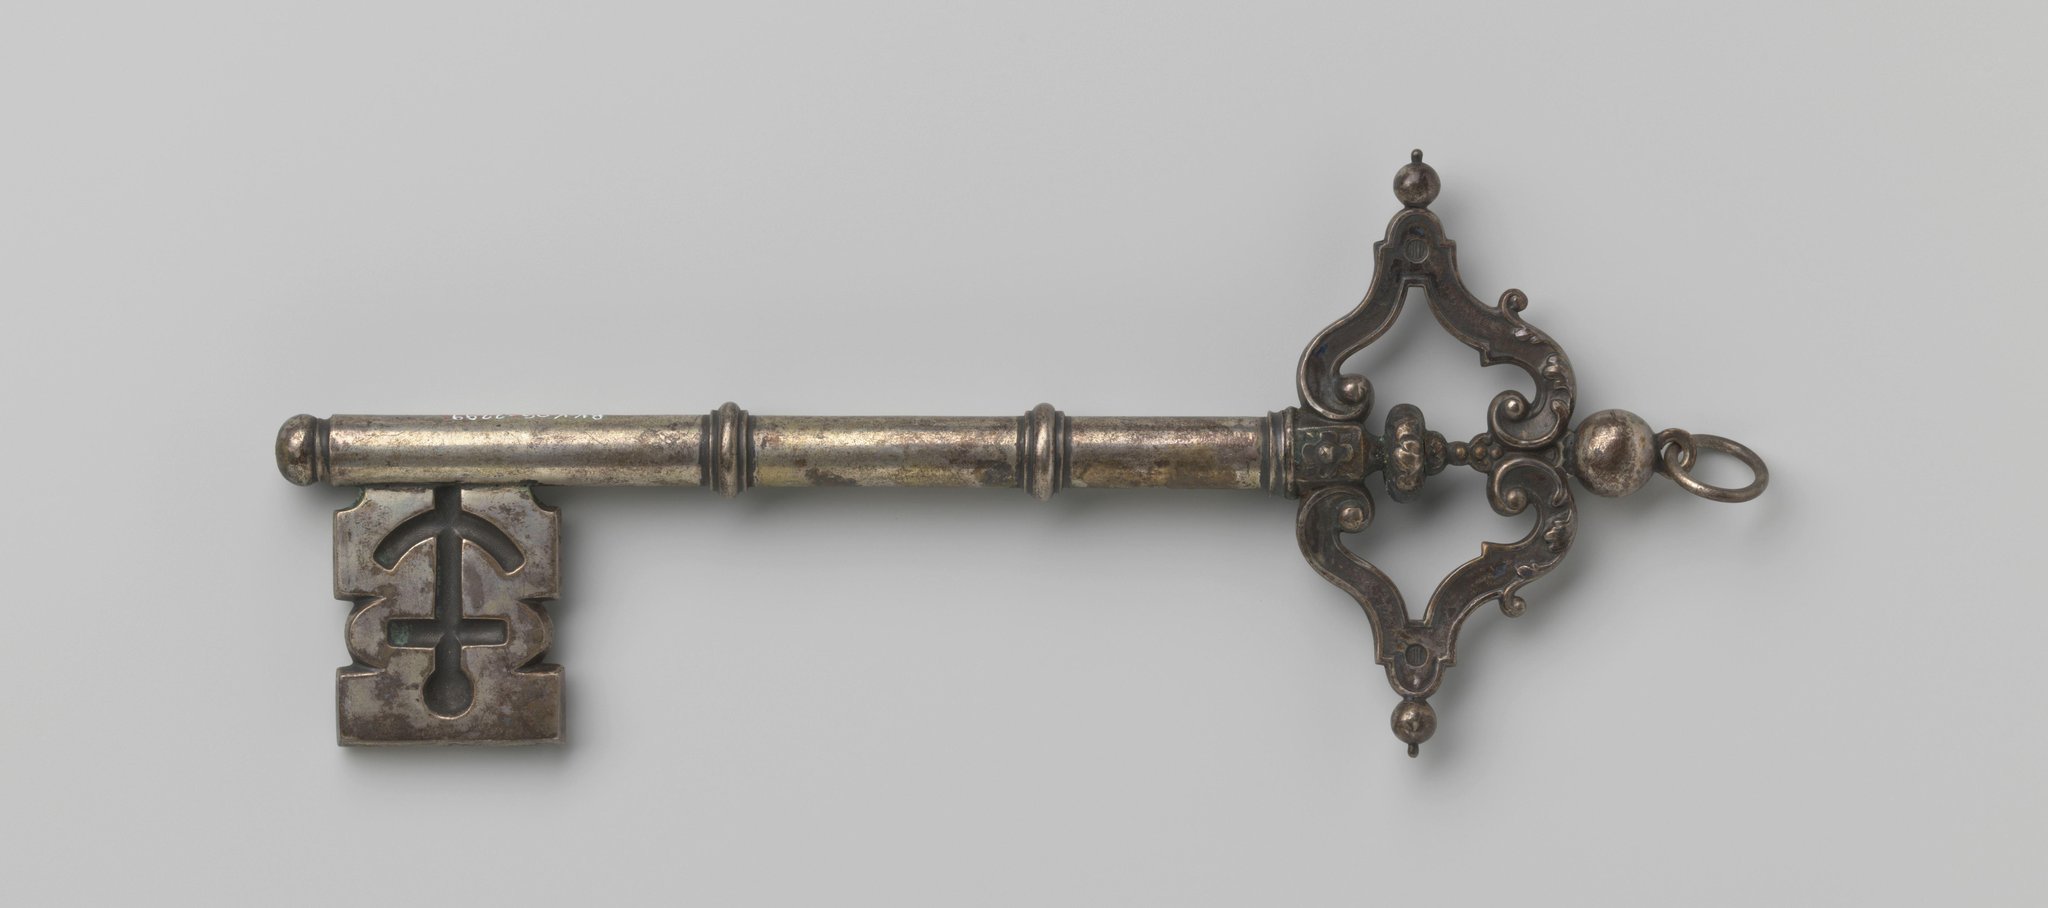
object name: key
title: Sleutel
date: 1800-1900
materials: silver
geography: france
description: Sleutel waarvan de greep uit vier voluten bestaat en bekroond wordt door een kogeltje met oog en ring. De schacht wordt door twee ringvormige verdikkingen in drieen verdeeld. De baard heeft aan beide zijden een ankervormige verdieping. Op het oog zilvermerk B.